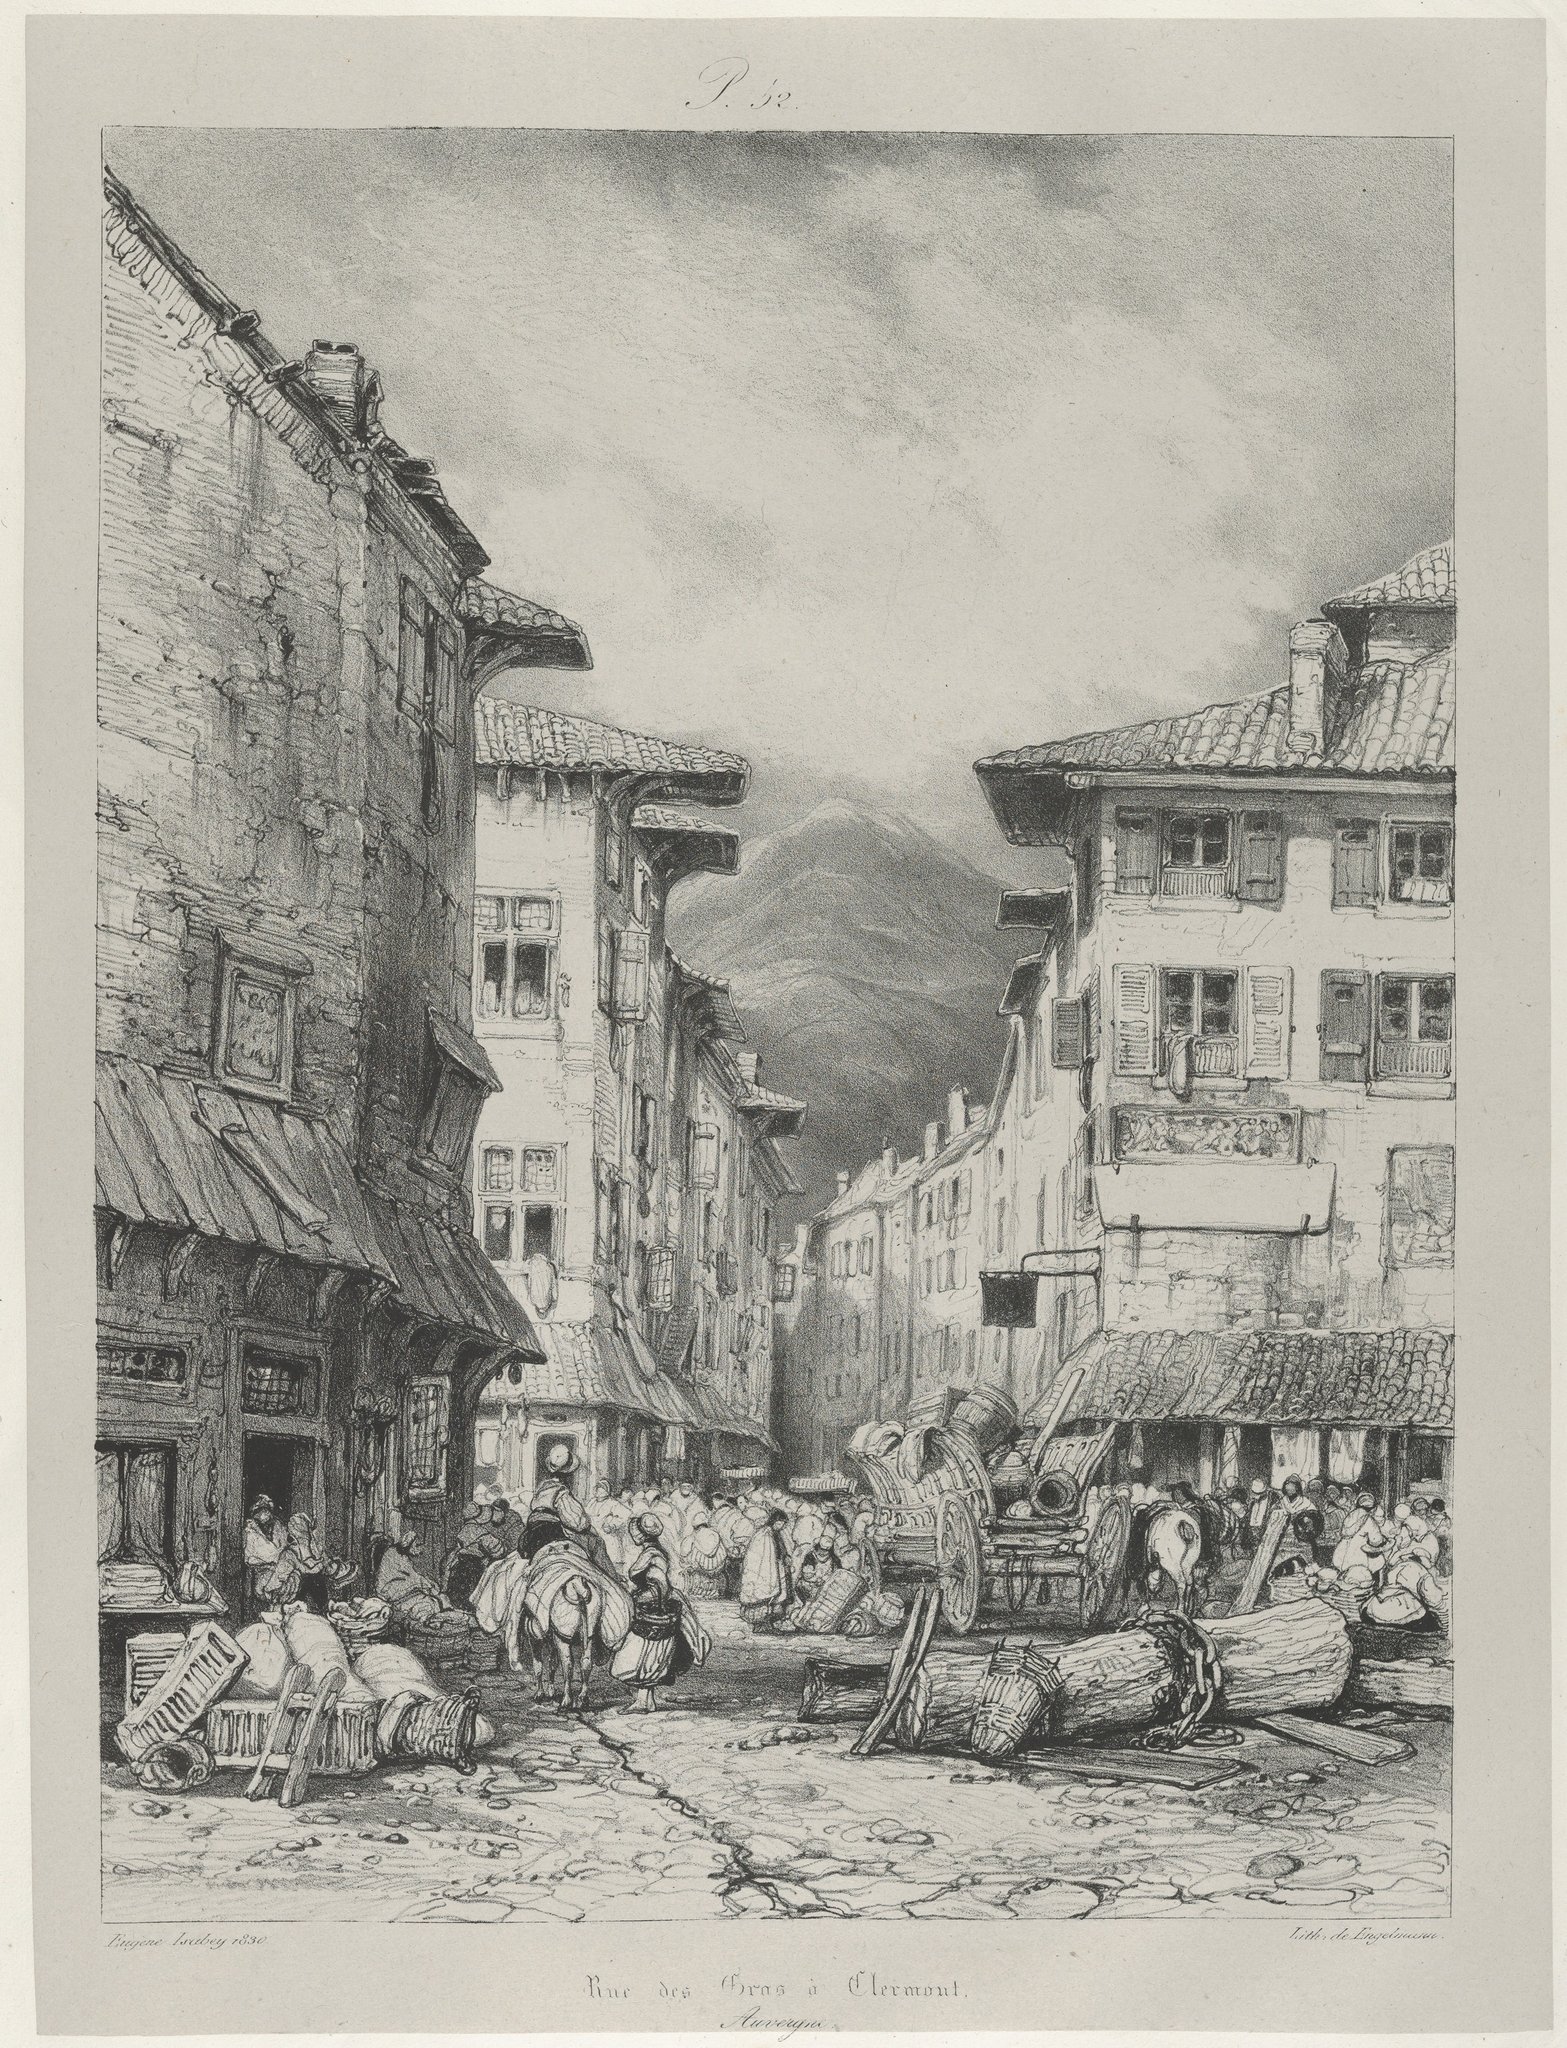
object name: print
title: Rue de Gros in Clermont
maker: eugène isabey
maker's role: artist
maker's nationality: french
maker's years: 1803-1886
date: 1833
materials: paper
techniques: printmaking, lithograph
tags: streets,towns,crowd